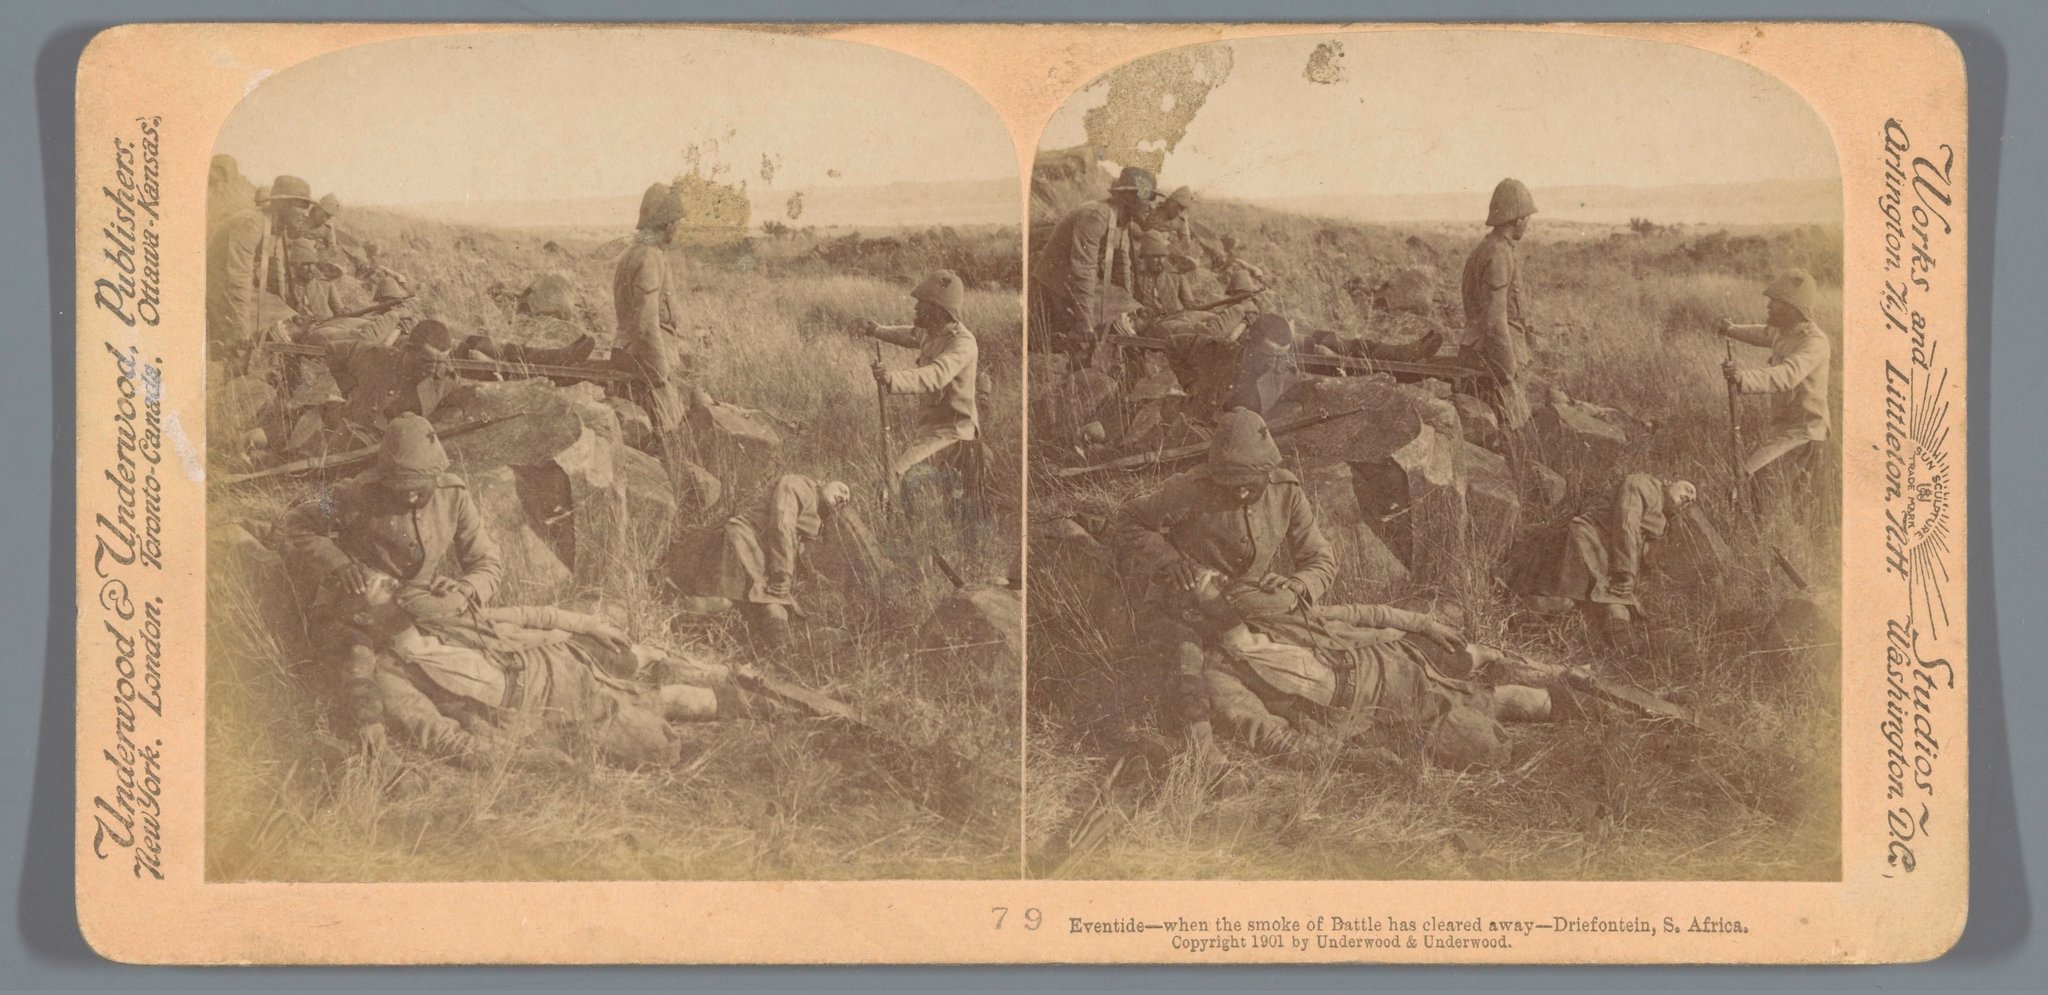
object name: stereograph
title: Voorstelling van rustende soldaten bij Driefontein, Zuid-Afrika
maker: Anonymous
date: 1901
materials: cardboard, paper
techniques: albumen print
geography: new york city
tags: the soldier; the soldier's life, medical aid and nursing of the sick and wounded on the battlefield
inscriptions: copyright notice: ‘Copyright 1901 by Underwood and Underwood.’, number: ‘79’, inscription, inscription: ‘Works and Studios ~/ Arlington, N.J. Littleton, N.H. Washington, D.C.’